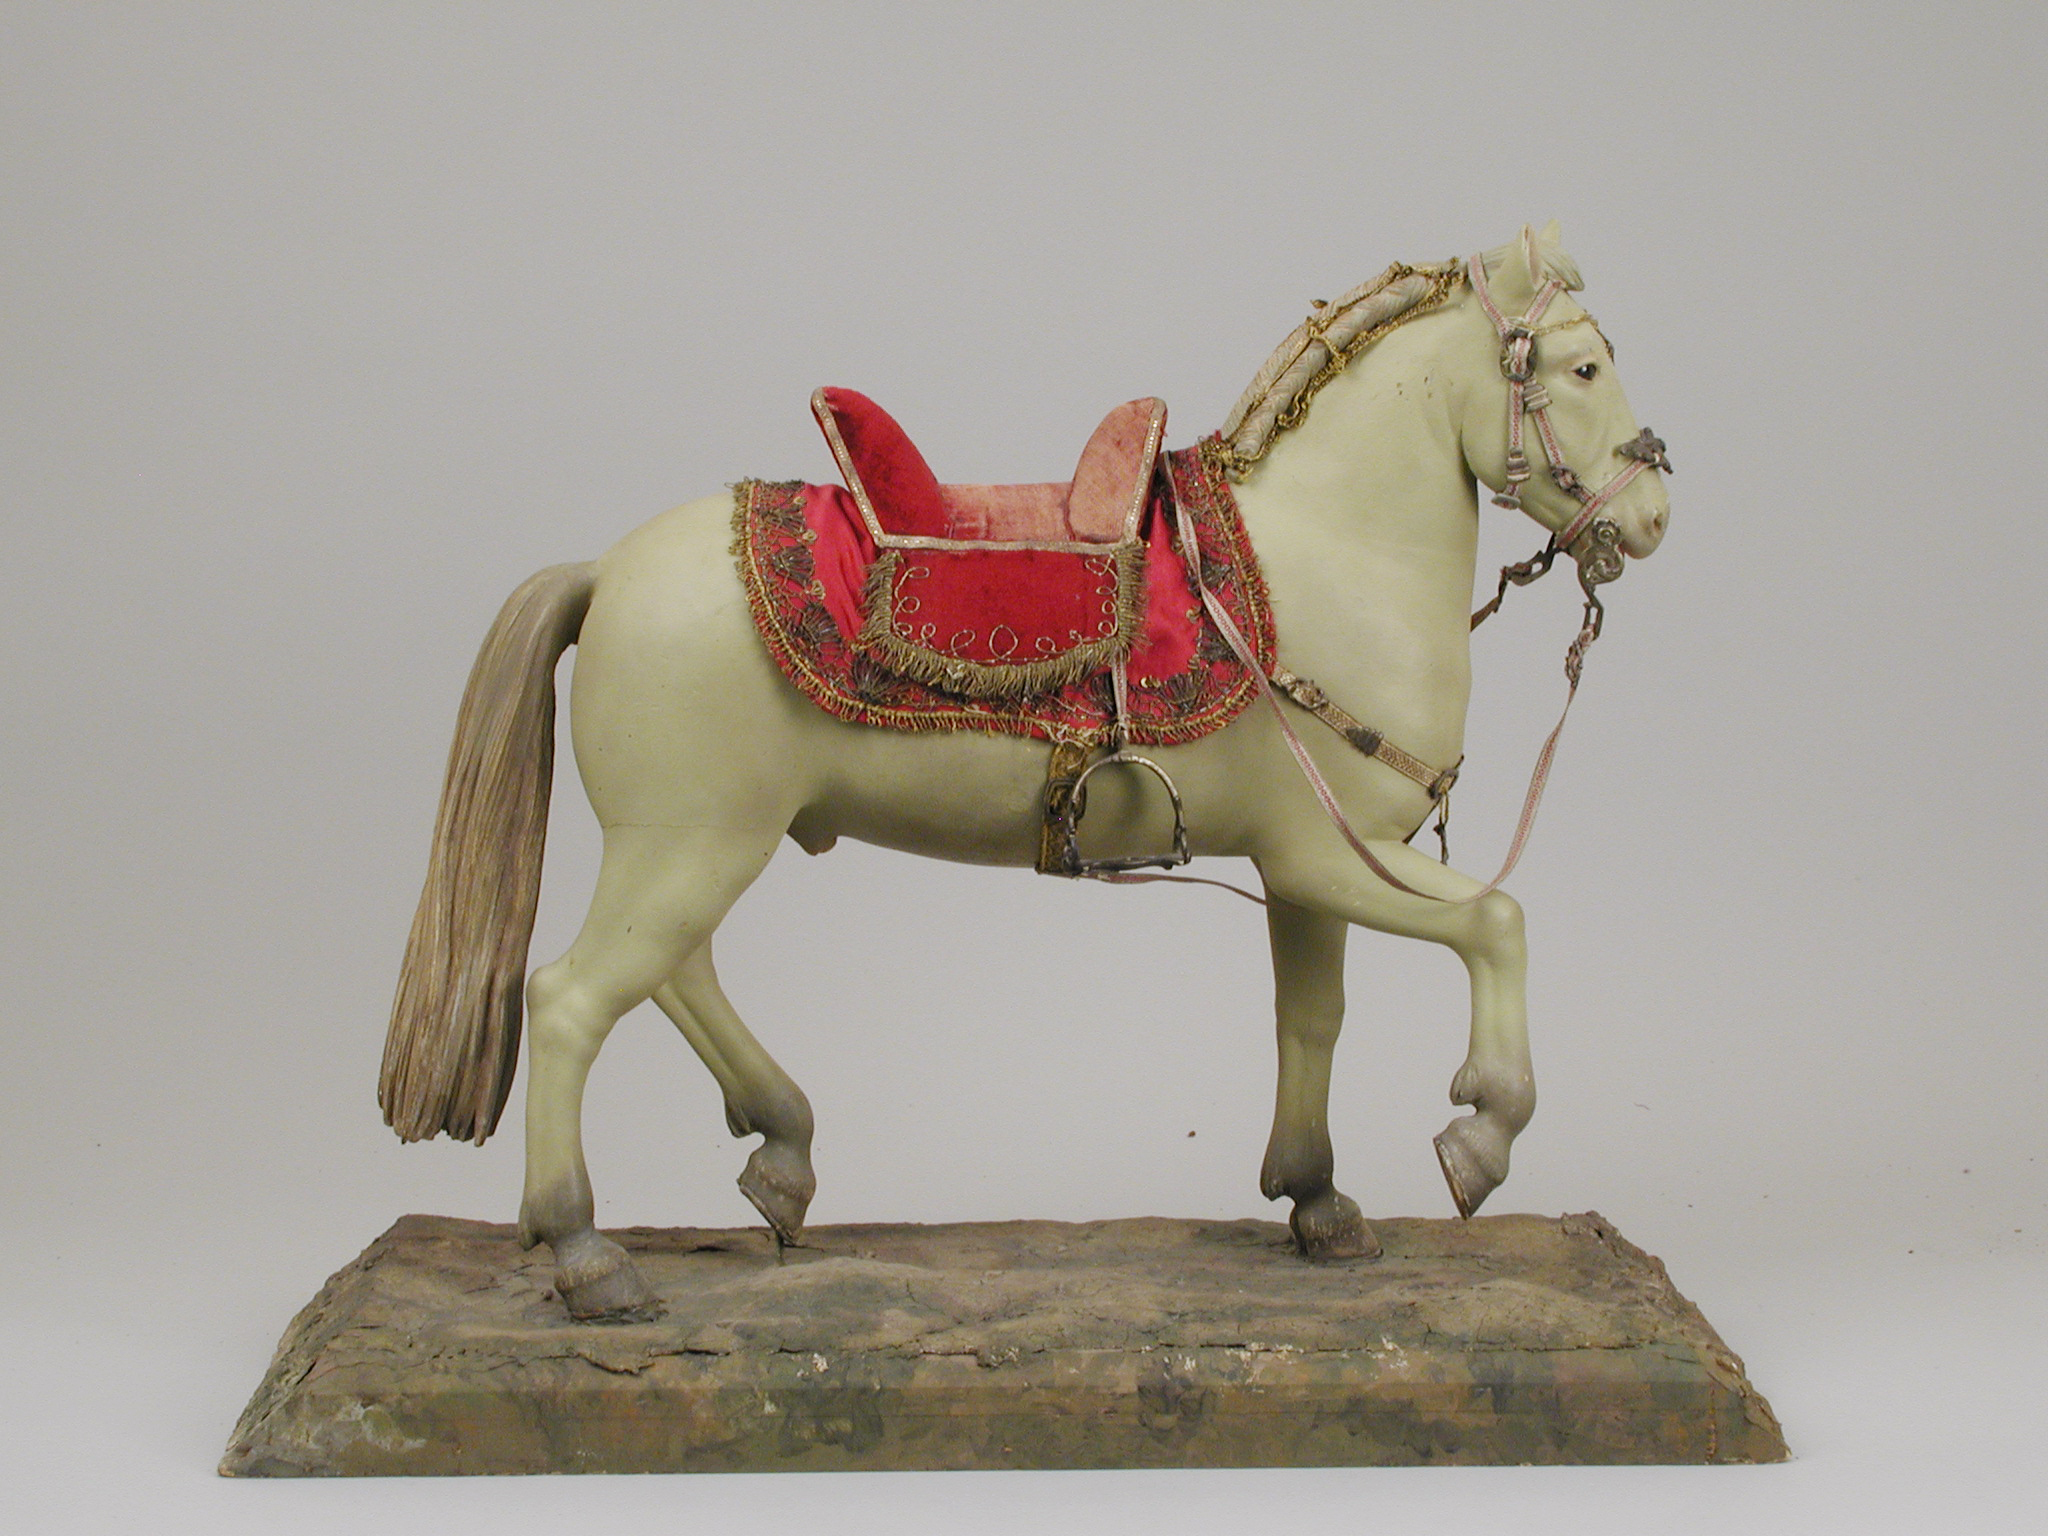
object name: crèche figure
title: Horse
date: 1751-1800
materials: gilt, gold, metal, metal thread, textile, silver, terracotta, velvet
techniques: polychrome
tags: horses